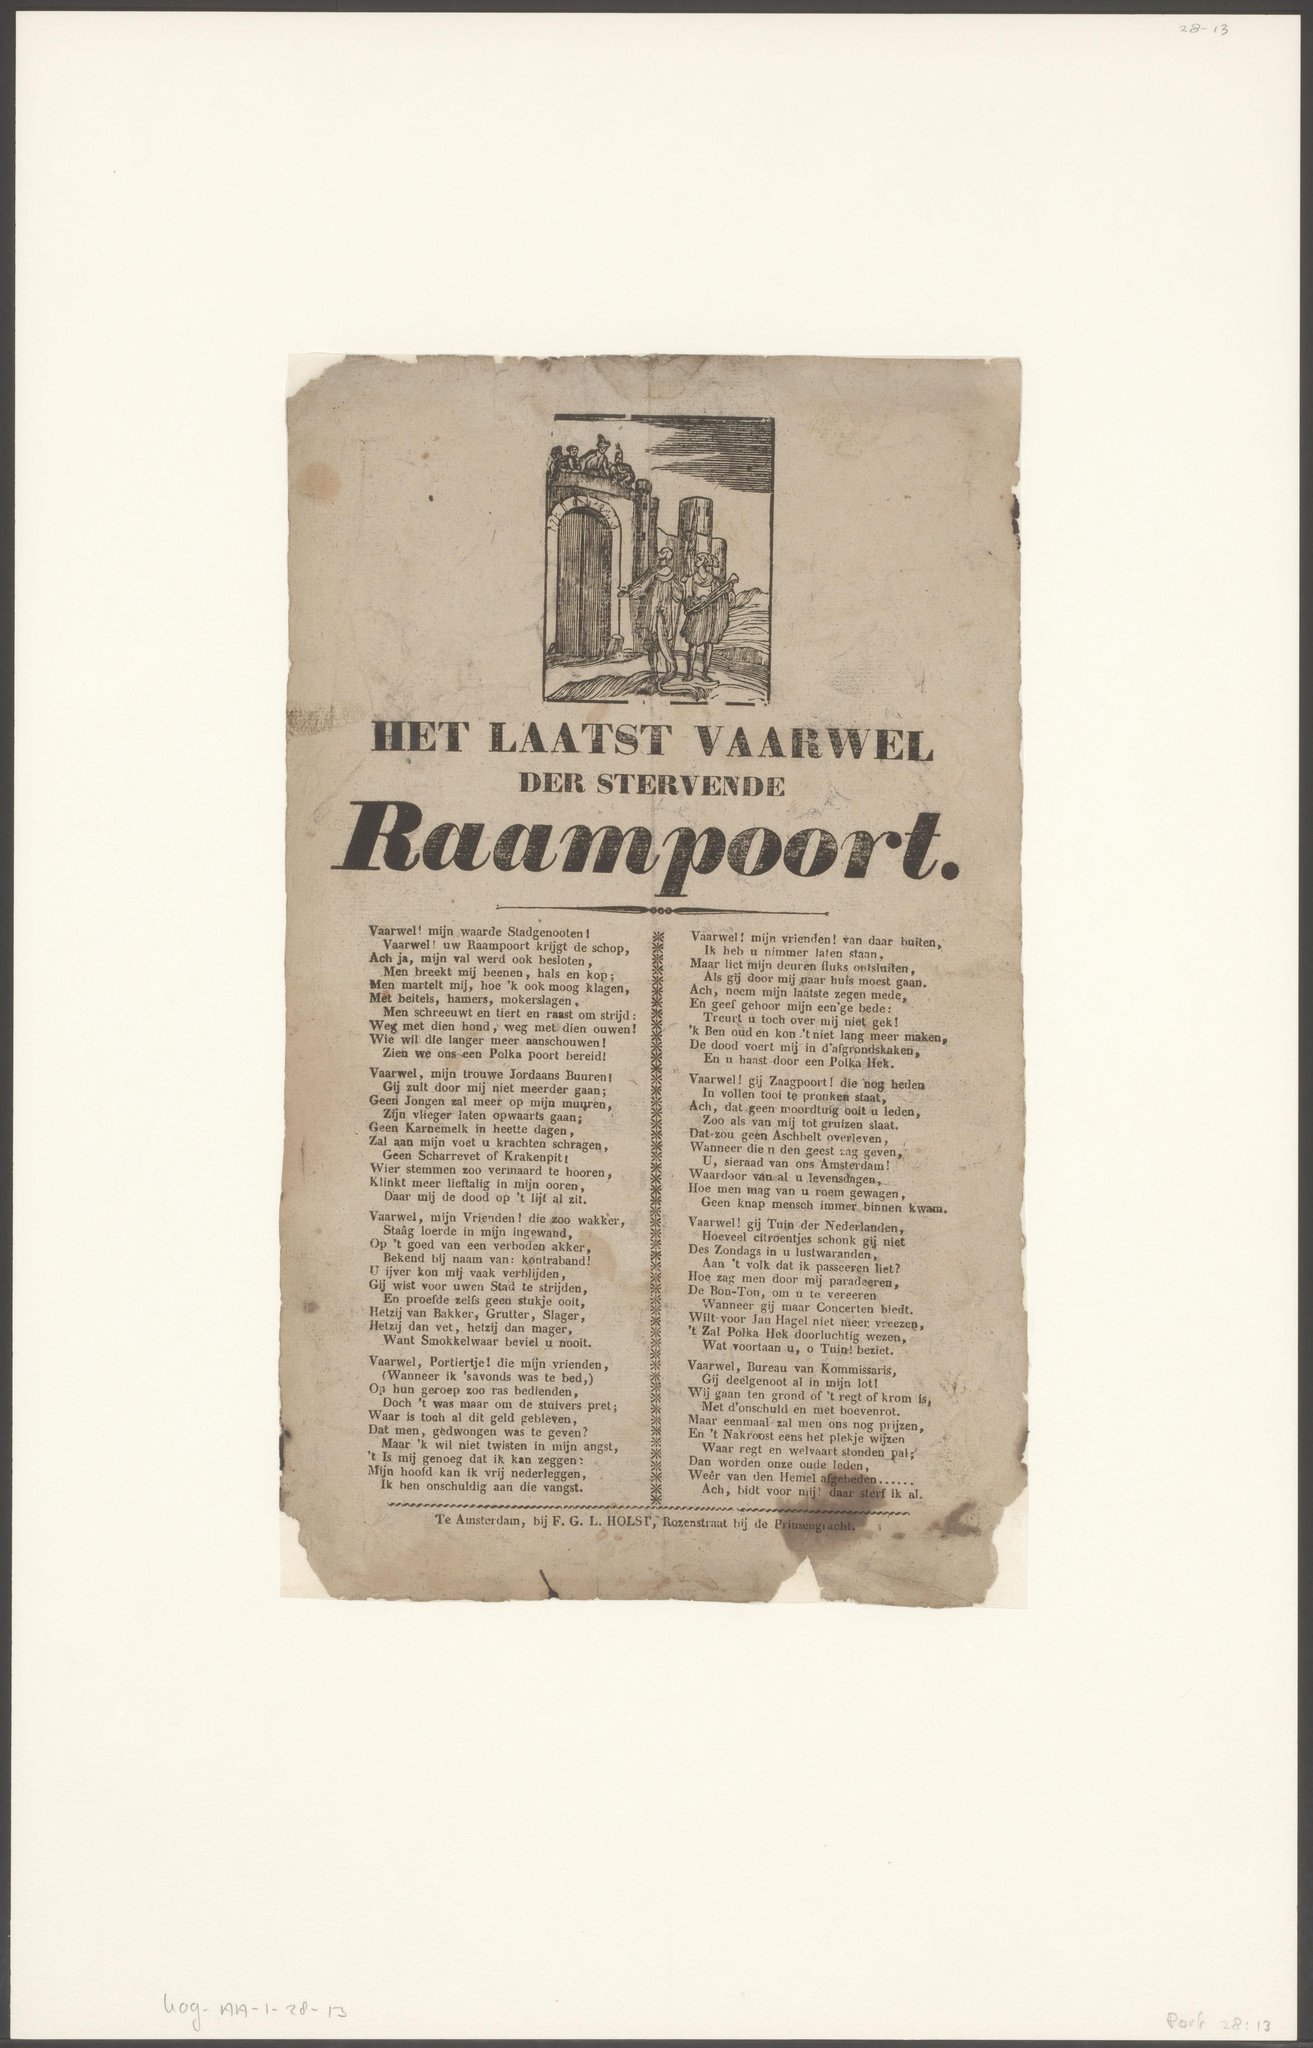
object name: book illustration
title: Afscheidsvers op de Raampoort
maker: Anonymous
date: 1844-1845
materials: paper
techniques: letterpress printing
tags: city-gate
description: Vers over het afbreken van de Raampoort in twee kolommen. Bovenaan een vignet waar twee mensen buiten de Raampoort staan. Onderwerpsrubriek binnen de Atlas Amsterdam: Poorten, verzamelbladen, A. Raampoort.